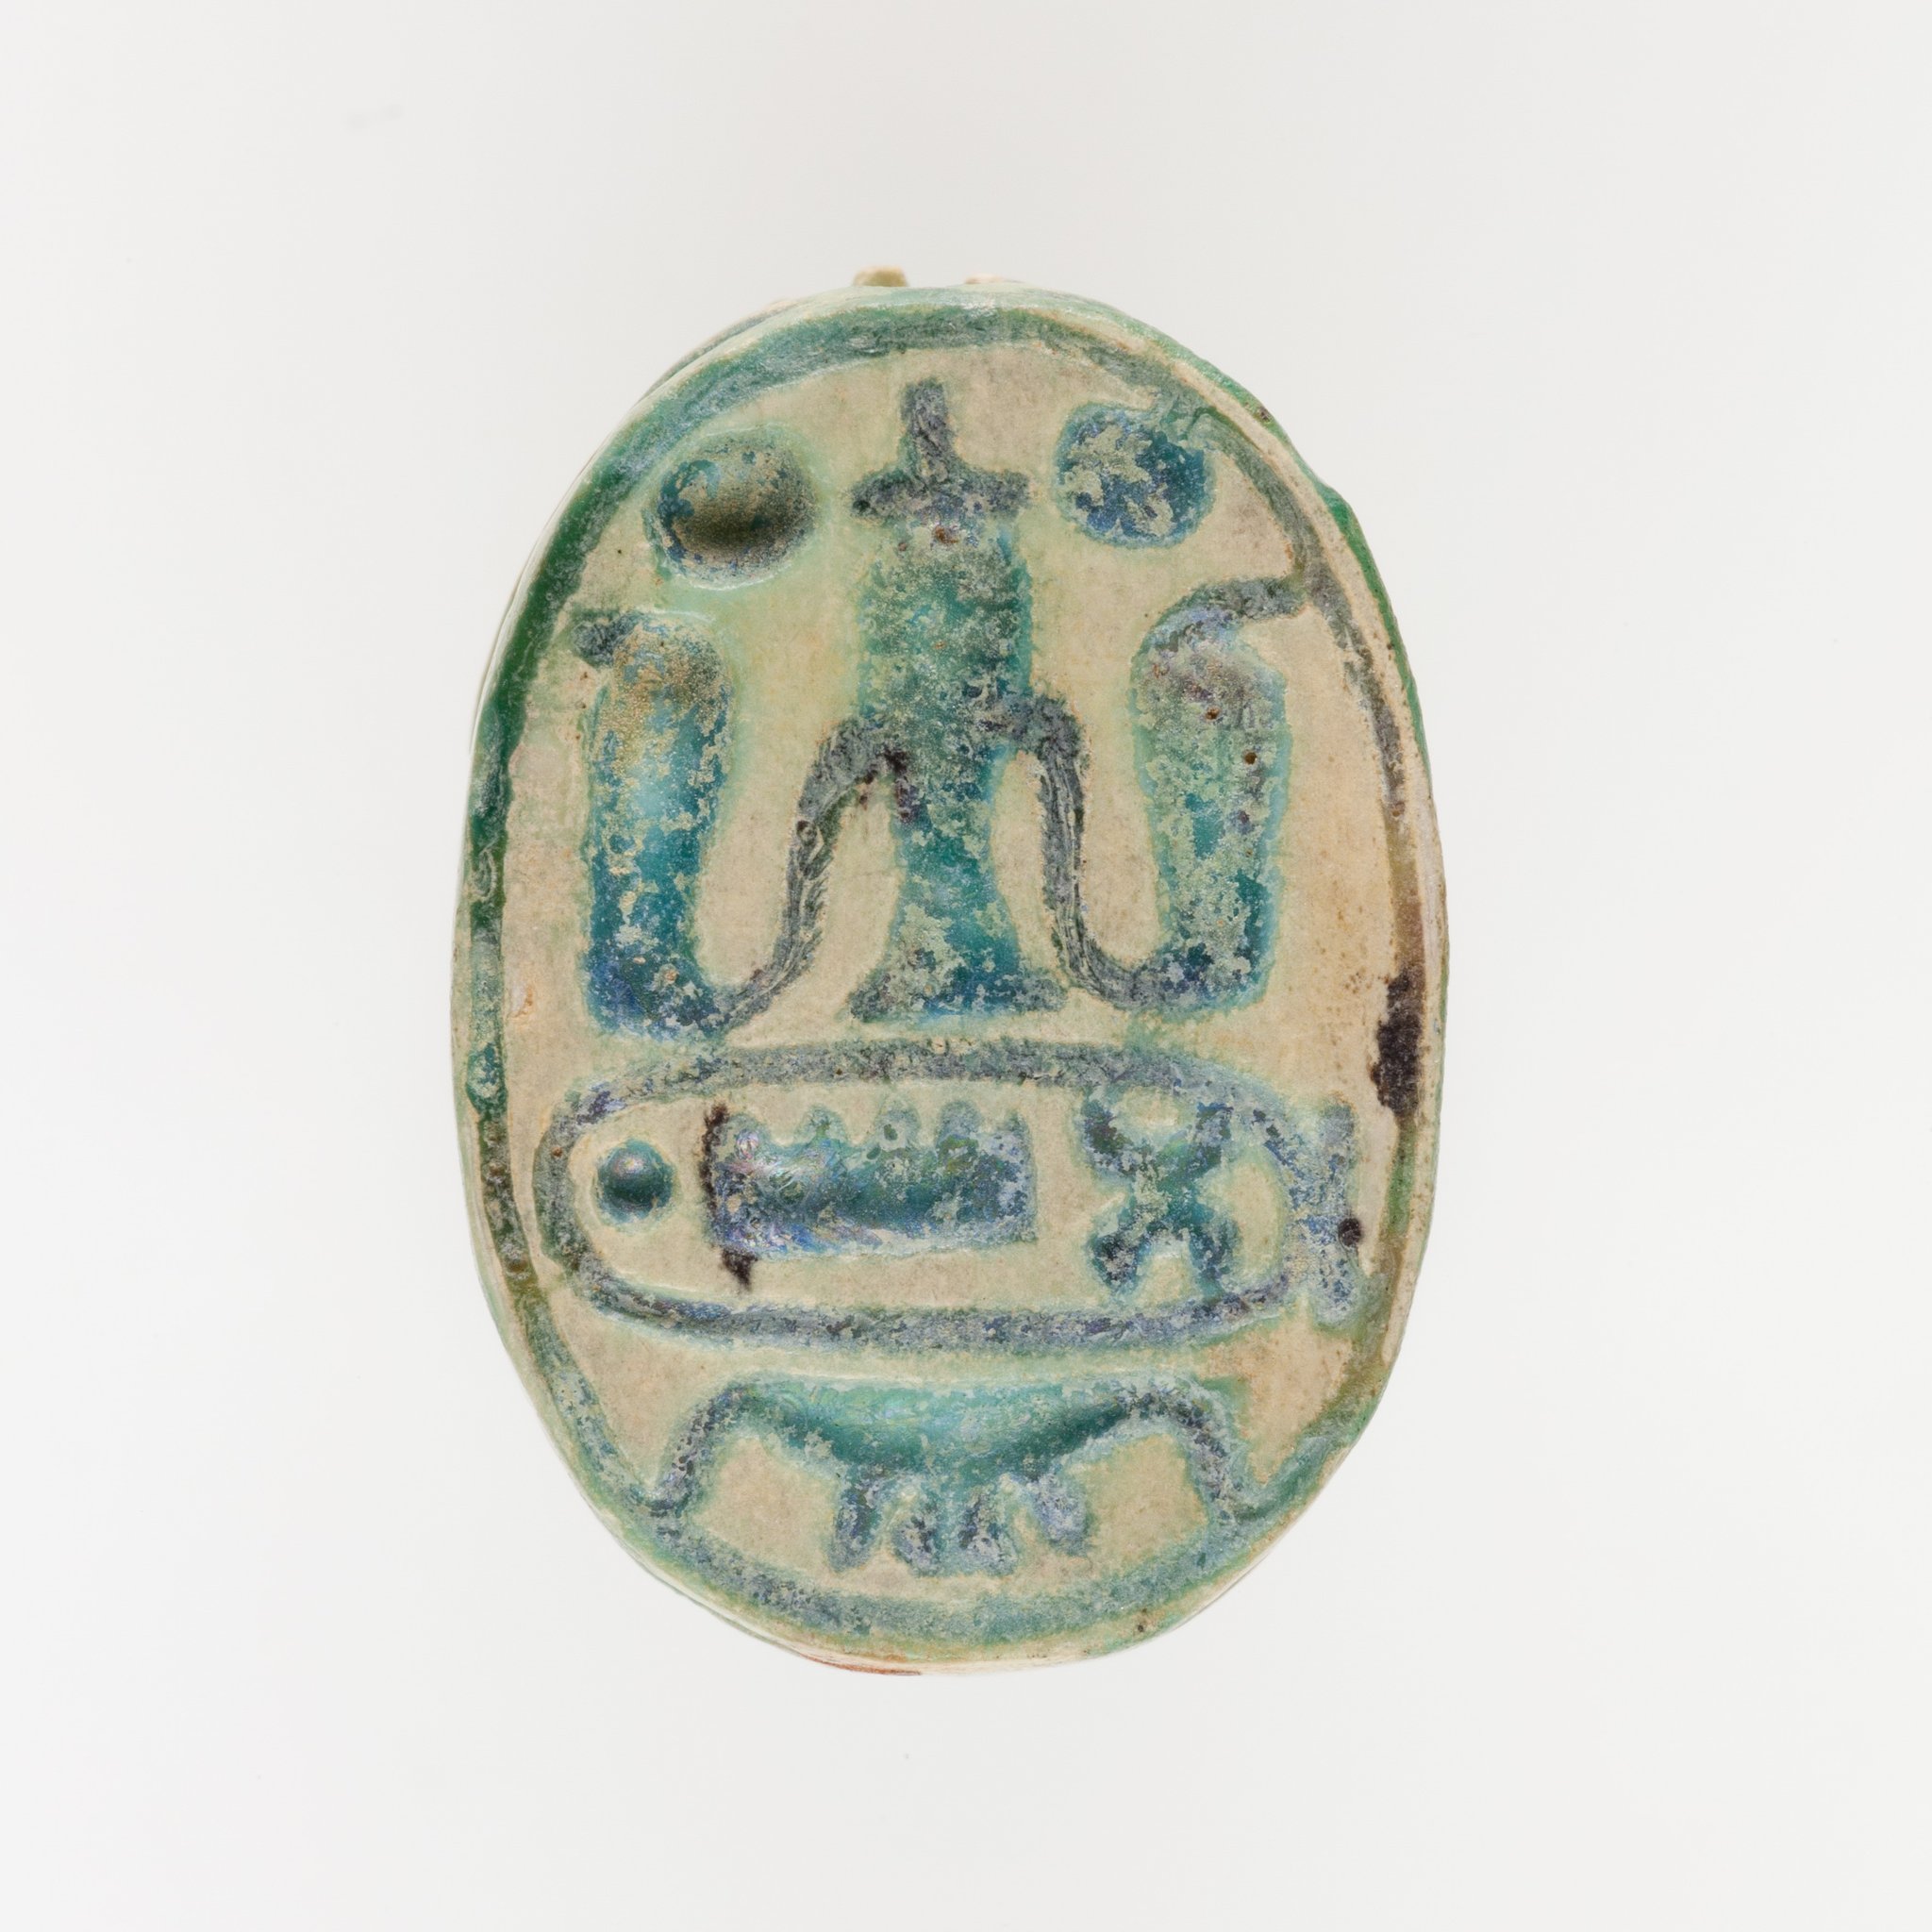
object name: scarab, thutmose iii, menkheperre, he vase, uraei, sun disk, cartouche, nub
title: Scarab of Thutmose III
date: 1479-1429 BCE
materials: stone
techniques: glazing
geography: egypt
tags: hieroglyphs,scarabs